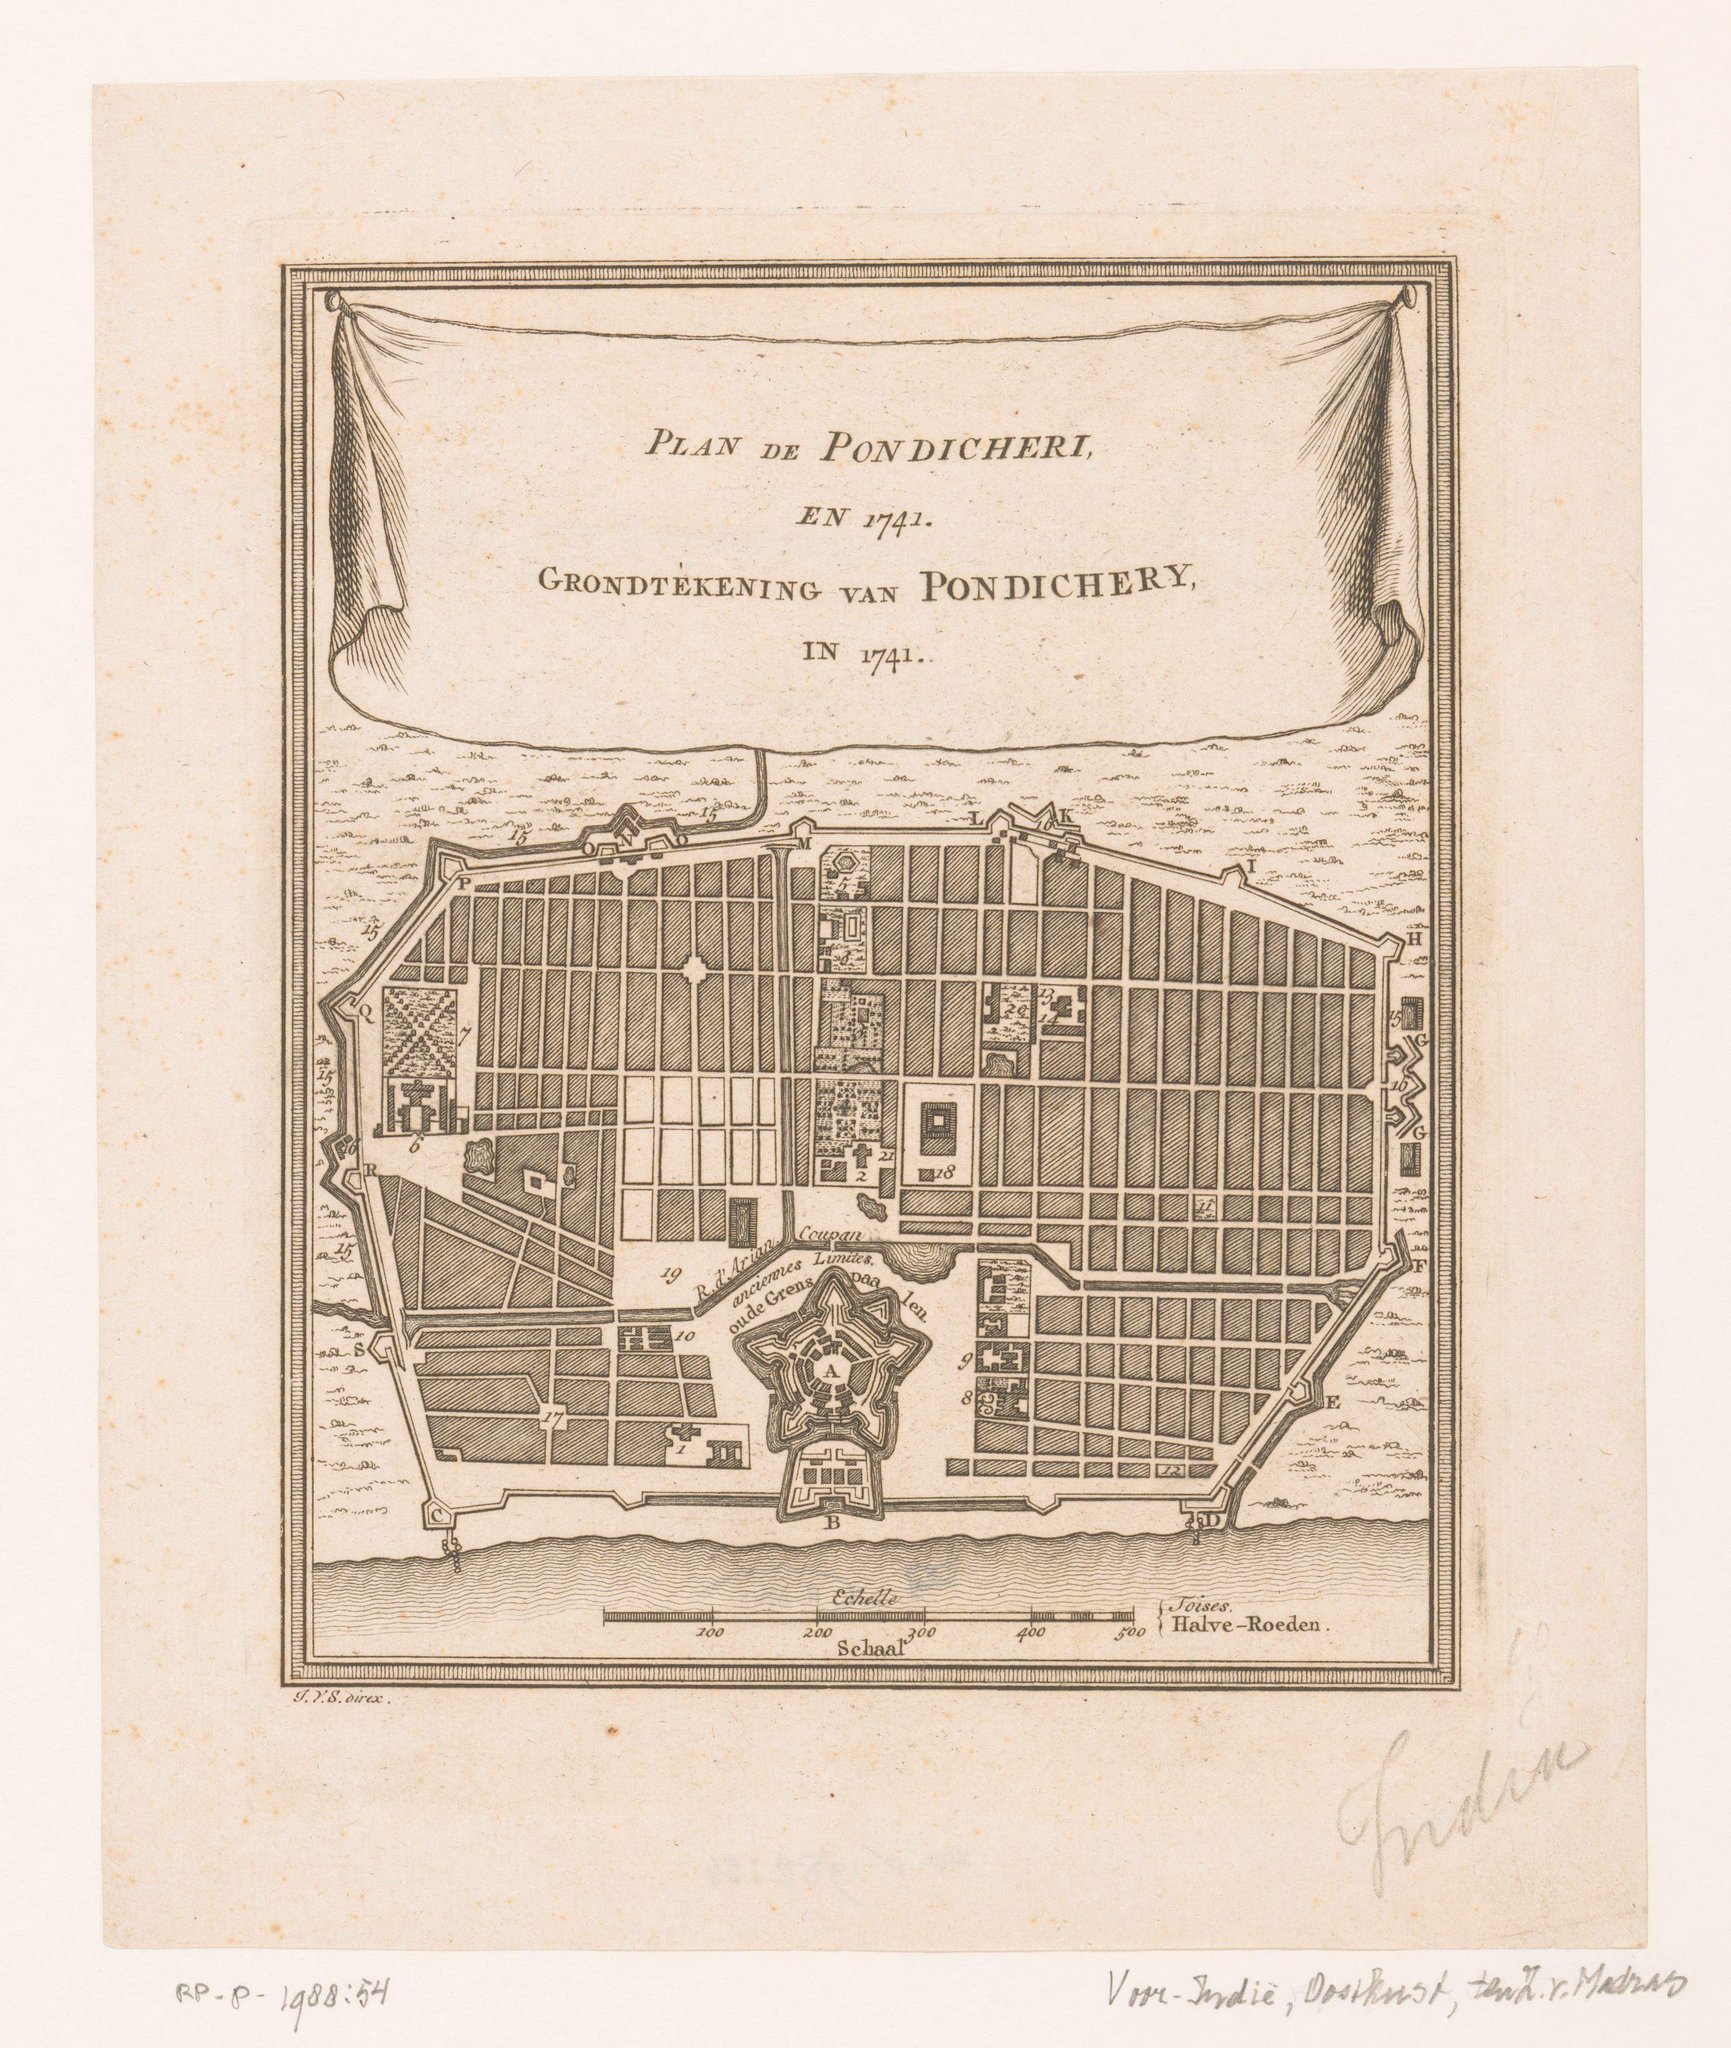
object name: area plan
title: Plan de Pondicheri, en 1741 / Grondtekening van Pondichery in 1741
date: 1767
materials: paper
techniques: engraving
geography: amsterdam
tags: maps of cities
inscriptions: collector's mark: Lugt 2760, collector's mark: Lugt 2228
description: Uit: Schley, J. van der. Historische beschryving der reizen (...). 21 dln. Den Haag: Pieter de Hondt (later Amsterdam: J. Roman et al), 1747-1767, dl. 16 (1767), p. 136-137.